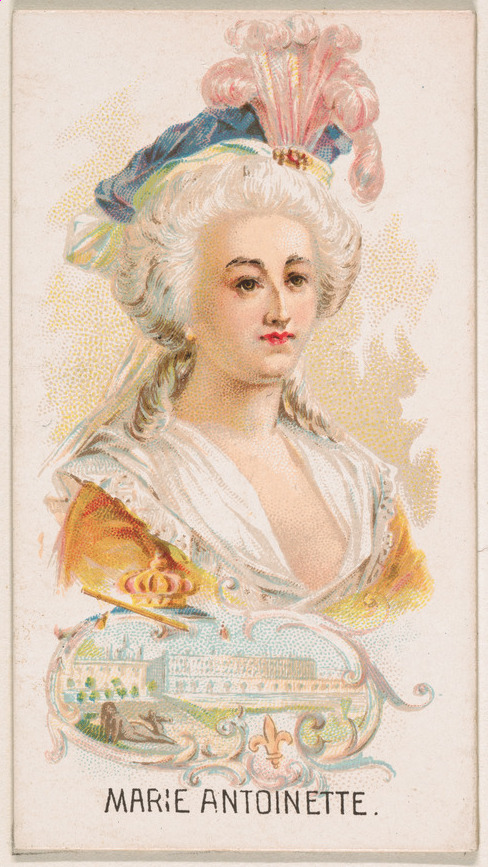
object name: print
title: Marie Antoinette, from Leaders series (N222) issued by Kinney Bros.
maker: kinney brothers tobacco company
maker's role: publisher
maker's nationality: american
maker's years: 1869-2011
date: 1888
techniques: color lithograph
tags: marie antoinette,women